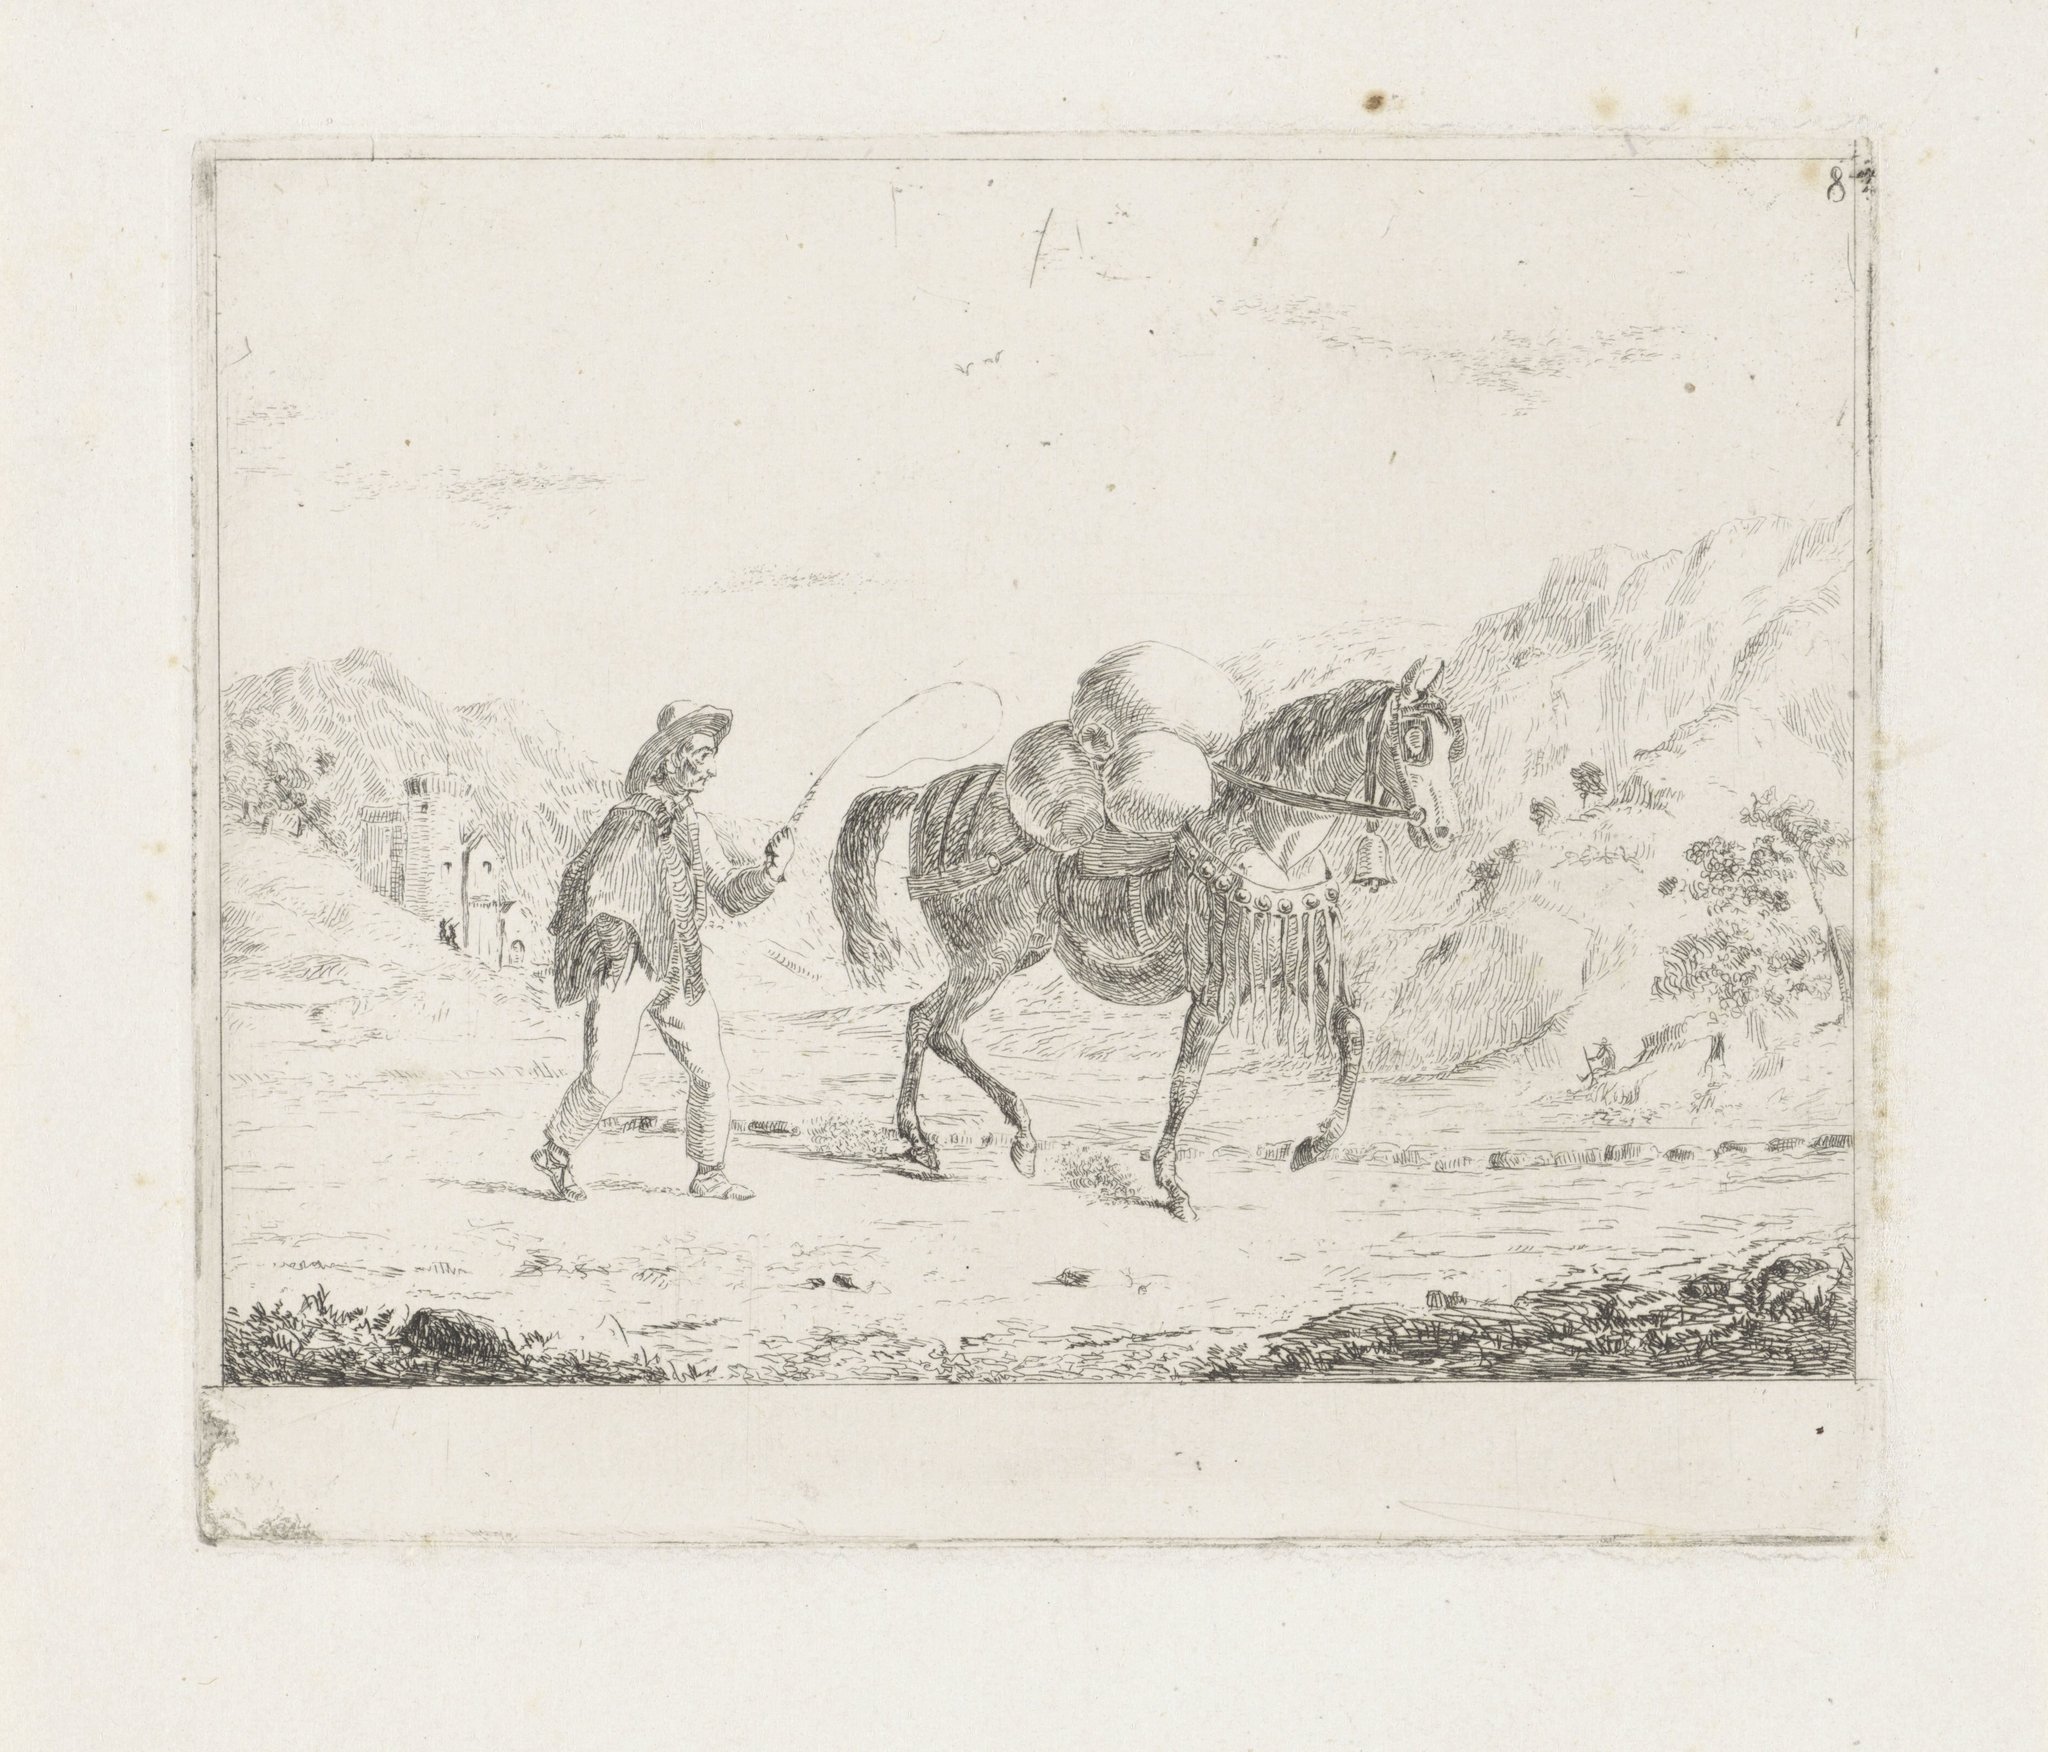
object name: print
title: Man met paard in heuvellandschap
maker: louis charles hora siccama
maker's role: draughtsman, print maker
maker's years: 1807-1880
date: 1875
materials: paper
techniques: etching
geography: utrecht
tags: animal mounts; pack-animals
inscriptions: collector's mark: Lugt 2228